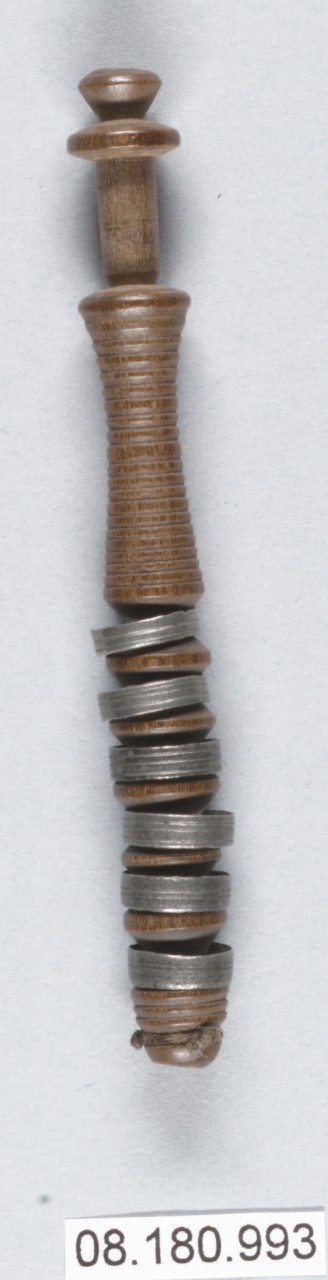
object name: bobbin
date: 1801-1900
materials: pewter, wood